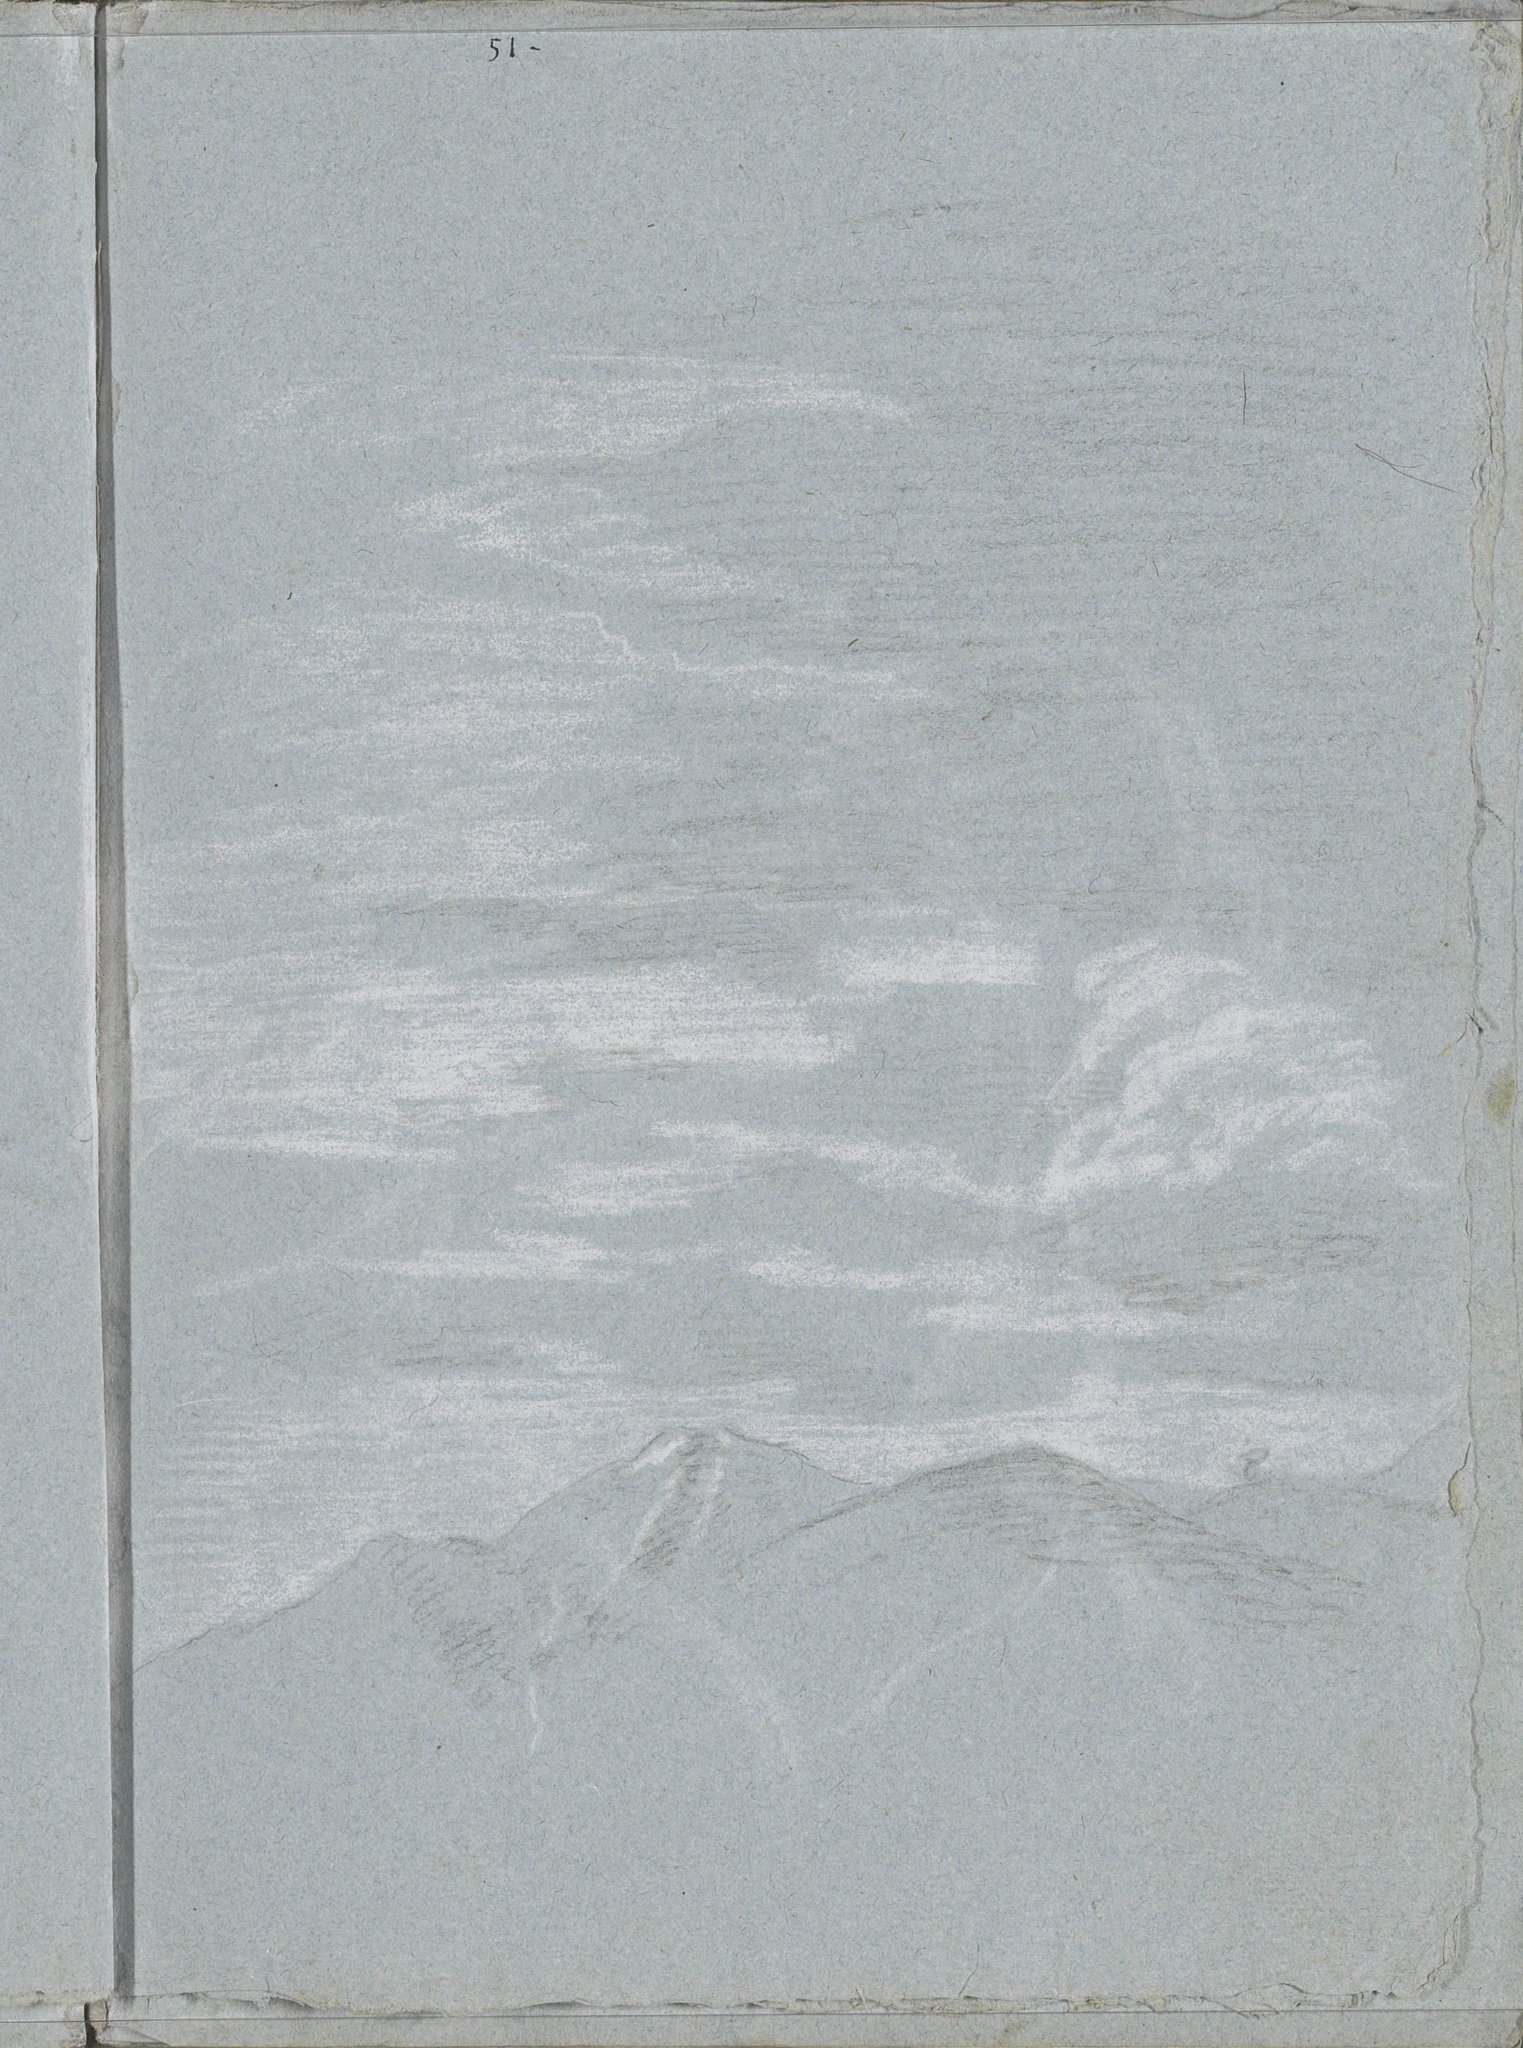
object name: sketchbook leaf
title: Berglandschap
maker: lorenzo baldissera tiepolo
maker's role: draughtsman, print maker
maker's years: 1736-1776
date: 1751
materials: chalk, paper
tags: mountains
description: Bladzijde 79 uit een schetsboek met 158 bladzijden.